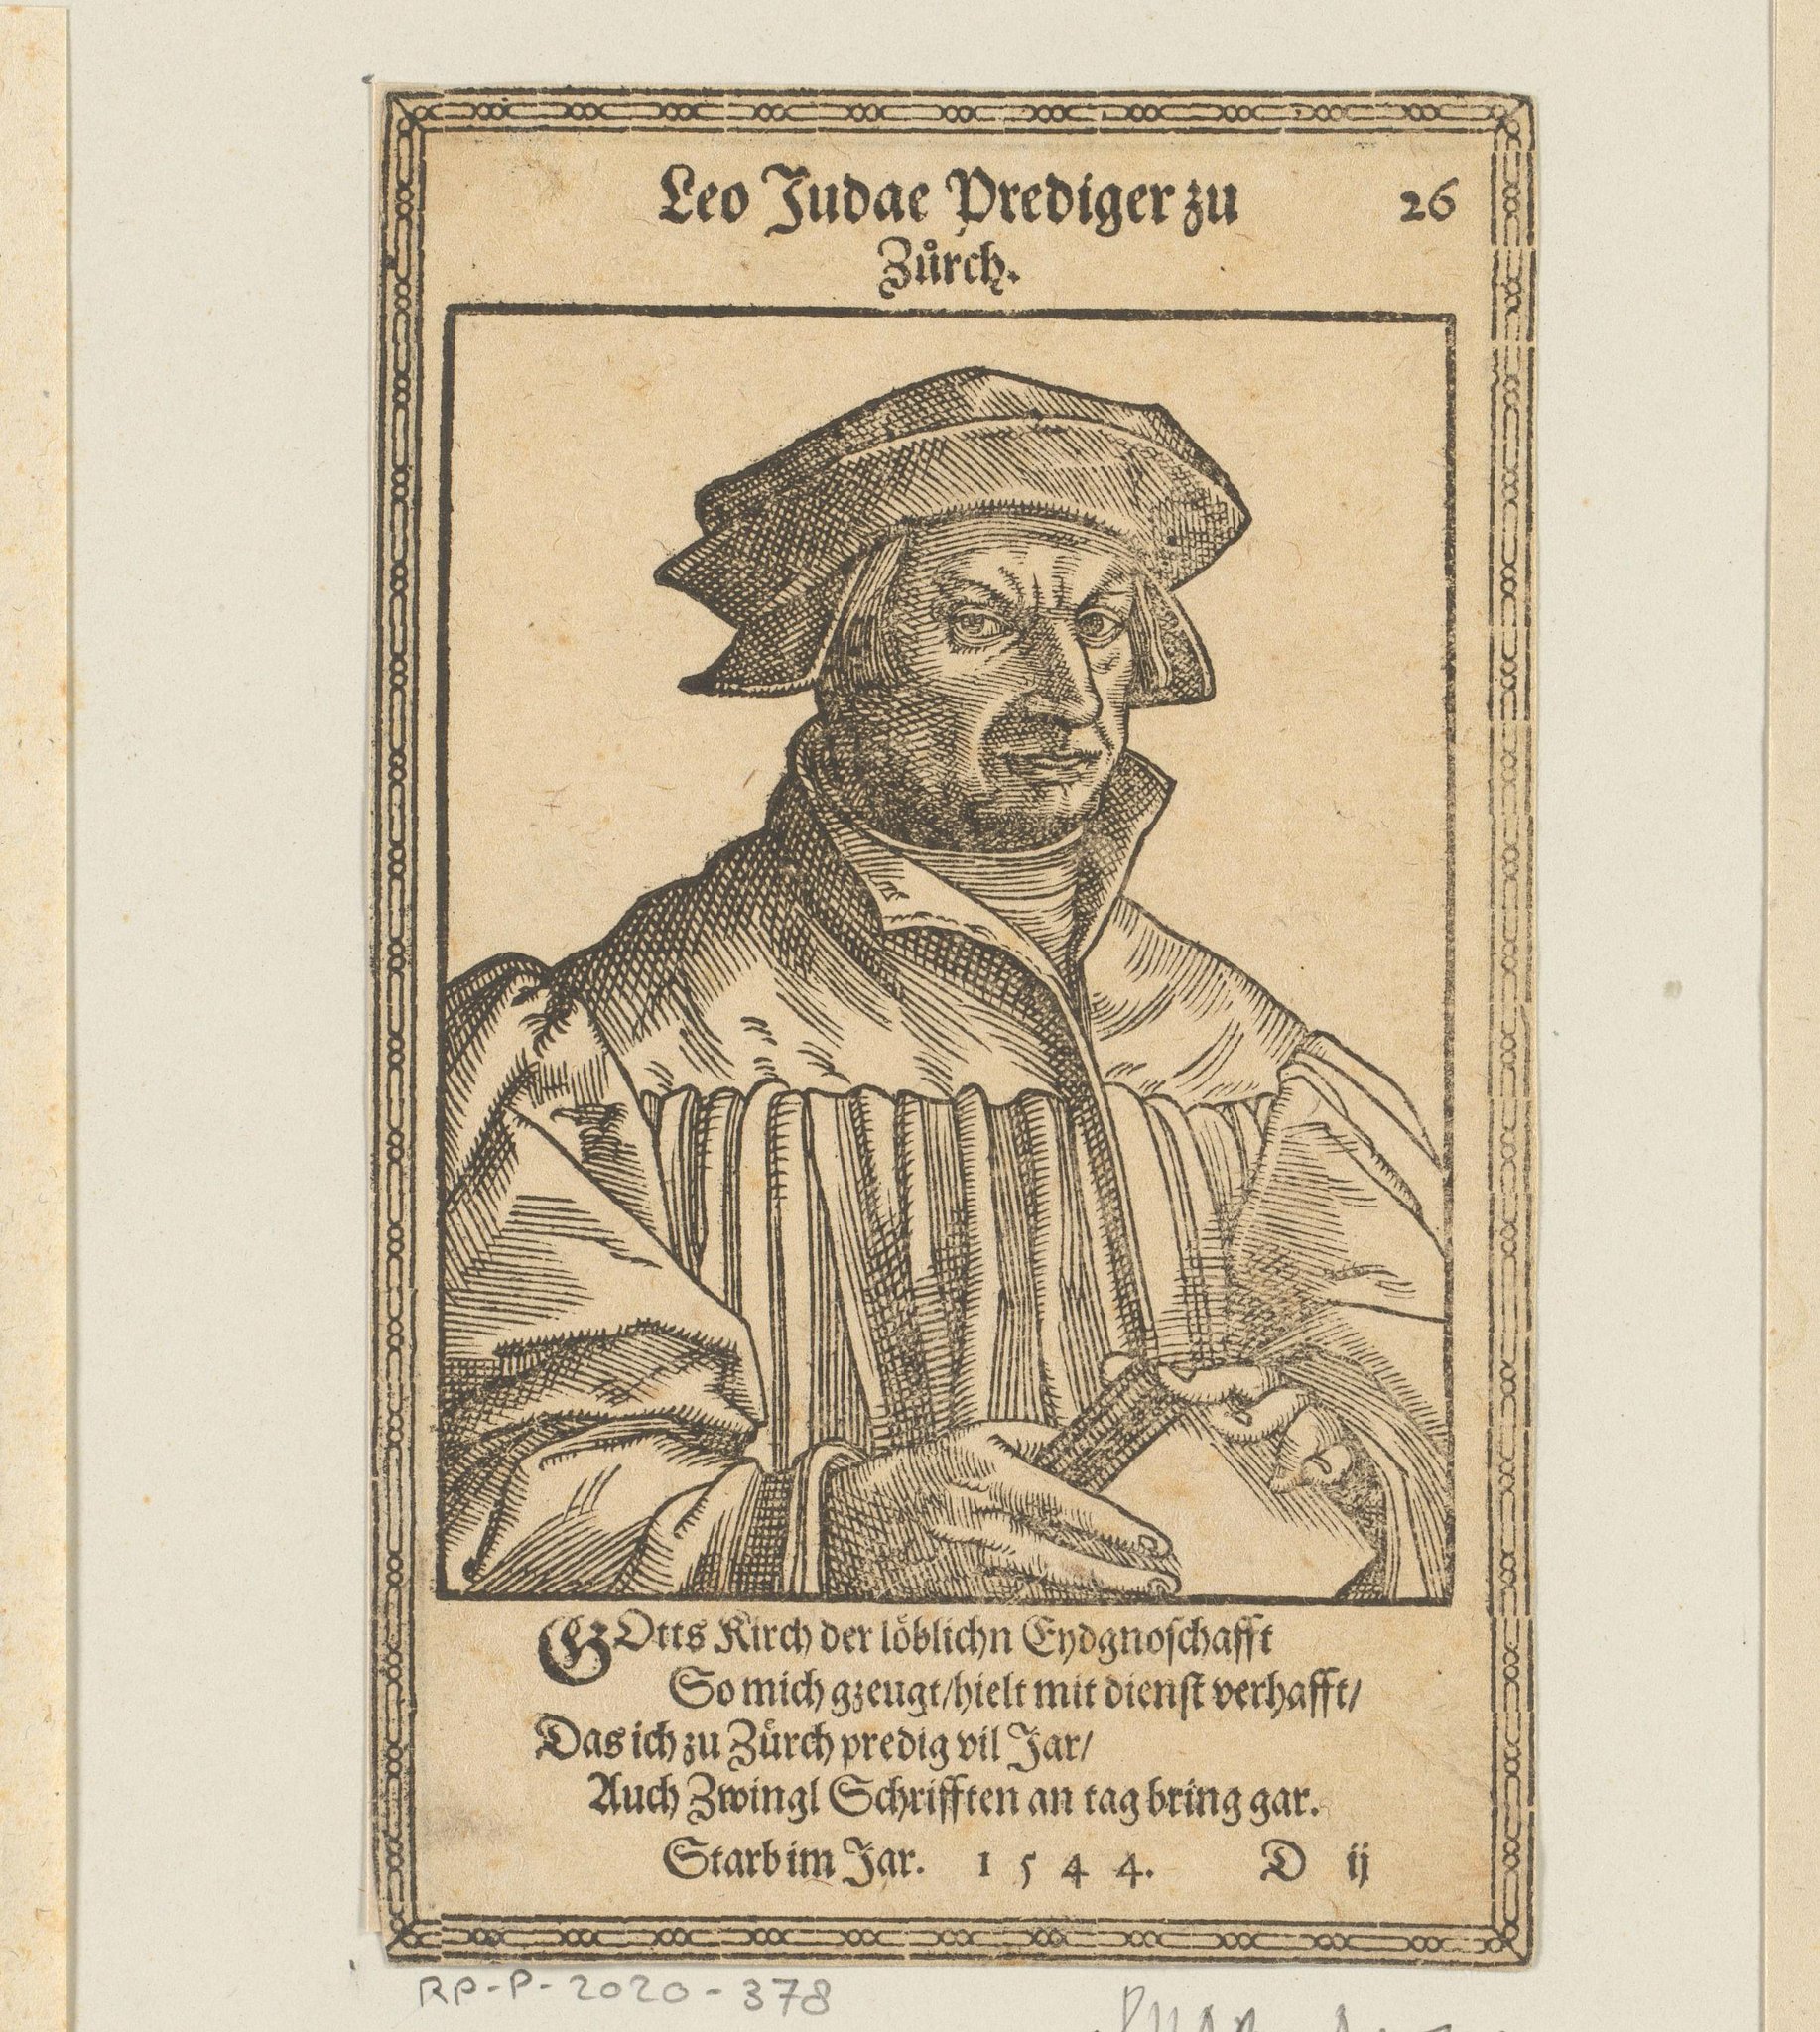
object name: book illustration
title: Portret van Leo Jud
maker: bernhard jobin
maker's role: printer, publisher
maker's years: 1545-1593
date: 1587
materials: paper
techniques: letterpress printing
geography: straatsburg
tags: theologian, historical persons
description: Prent uit: Reusner, Nikolaus. Contrafacturbuch: ware und lebendige Bildnussen etlicher weitberhümbten unnd hochgelehten Männer in Teutschland. Straatsburg: Bernhard Jobin, 1587, f. 26. Prent ook gebruikt in de Latijnse editie, uitgegeven in hetzelfde jaar, en de 1590-editie. Prent ook gebruikt in latere publicaties.